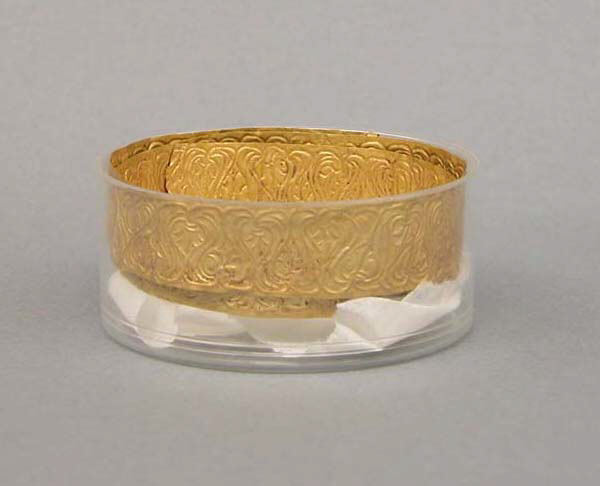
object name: diadem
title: Ritual Diadem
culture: indonesian, javanese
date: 201-300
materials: gold